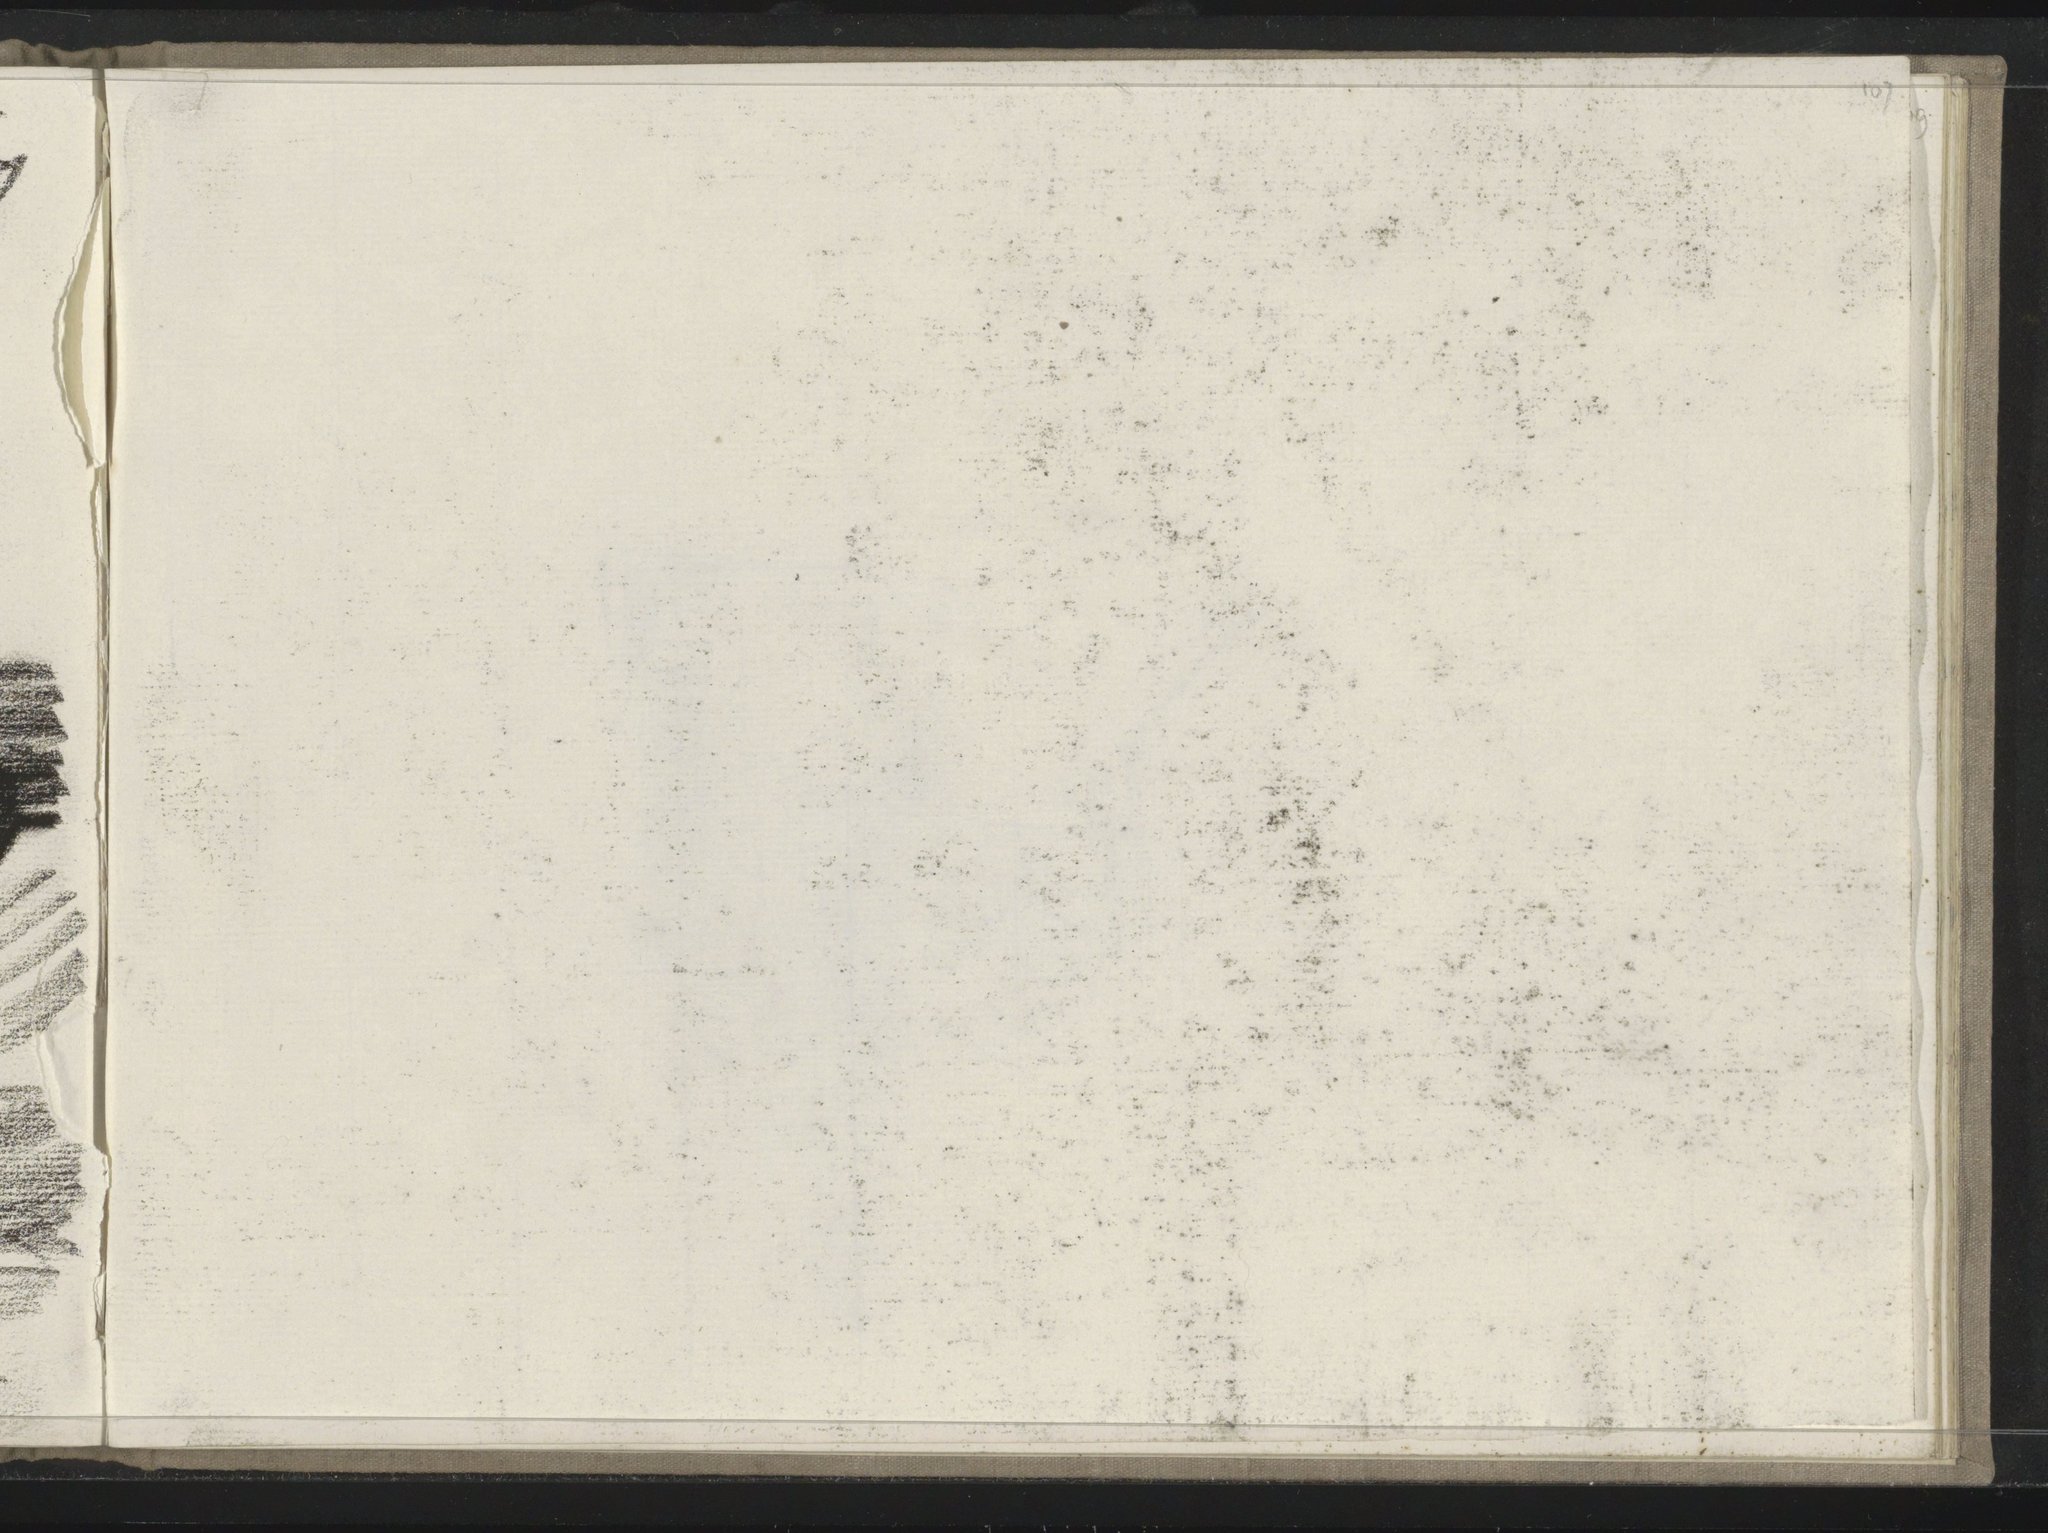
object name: sketchbook leaf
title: Abklatsch van de krijttekening op pagina 106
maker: willem witsen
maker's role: draughtsman, painter, print maker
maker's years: 1860-1923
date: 1888-1907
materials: paper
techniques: printmaking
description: Pagina 106 uit een schetsboek met 72 bladen.